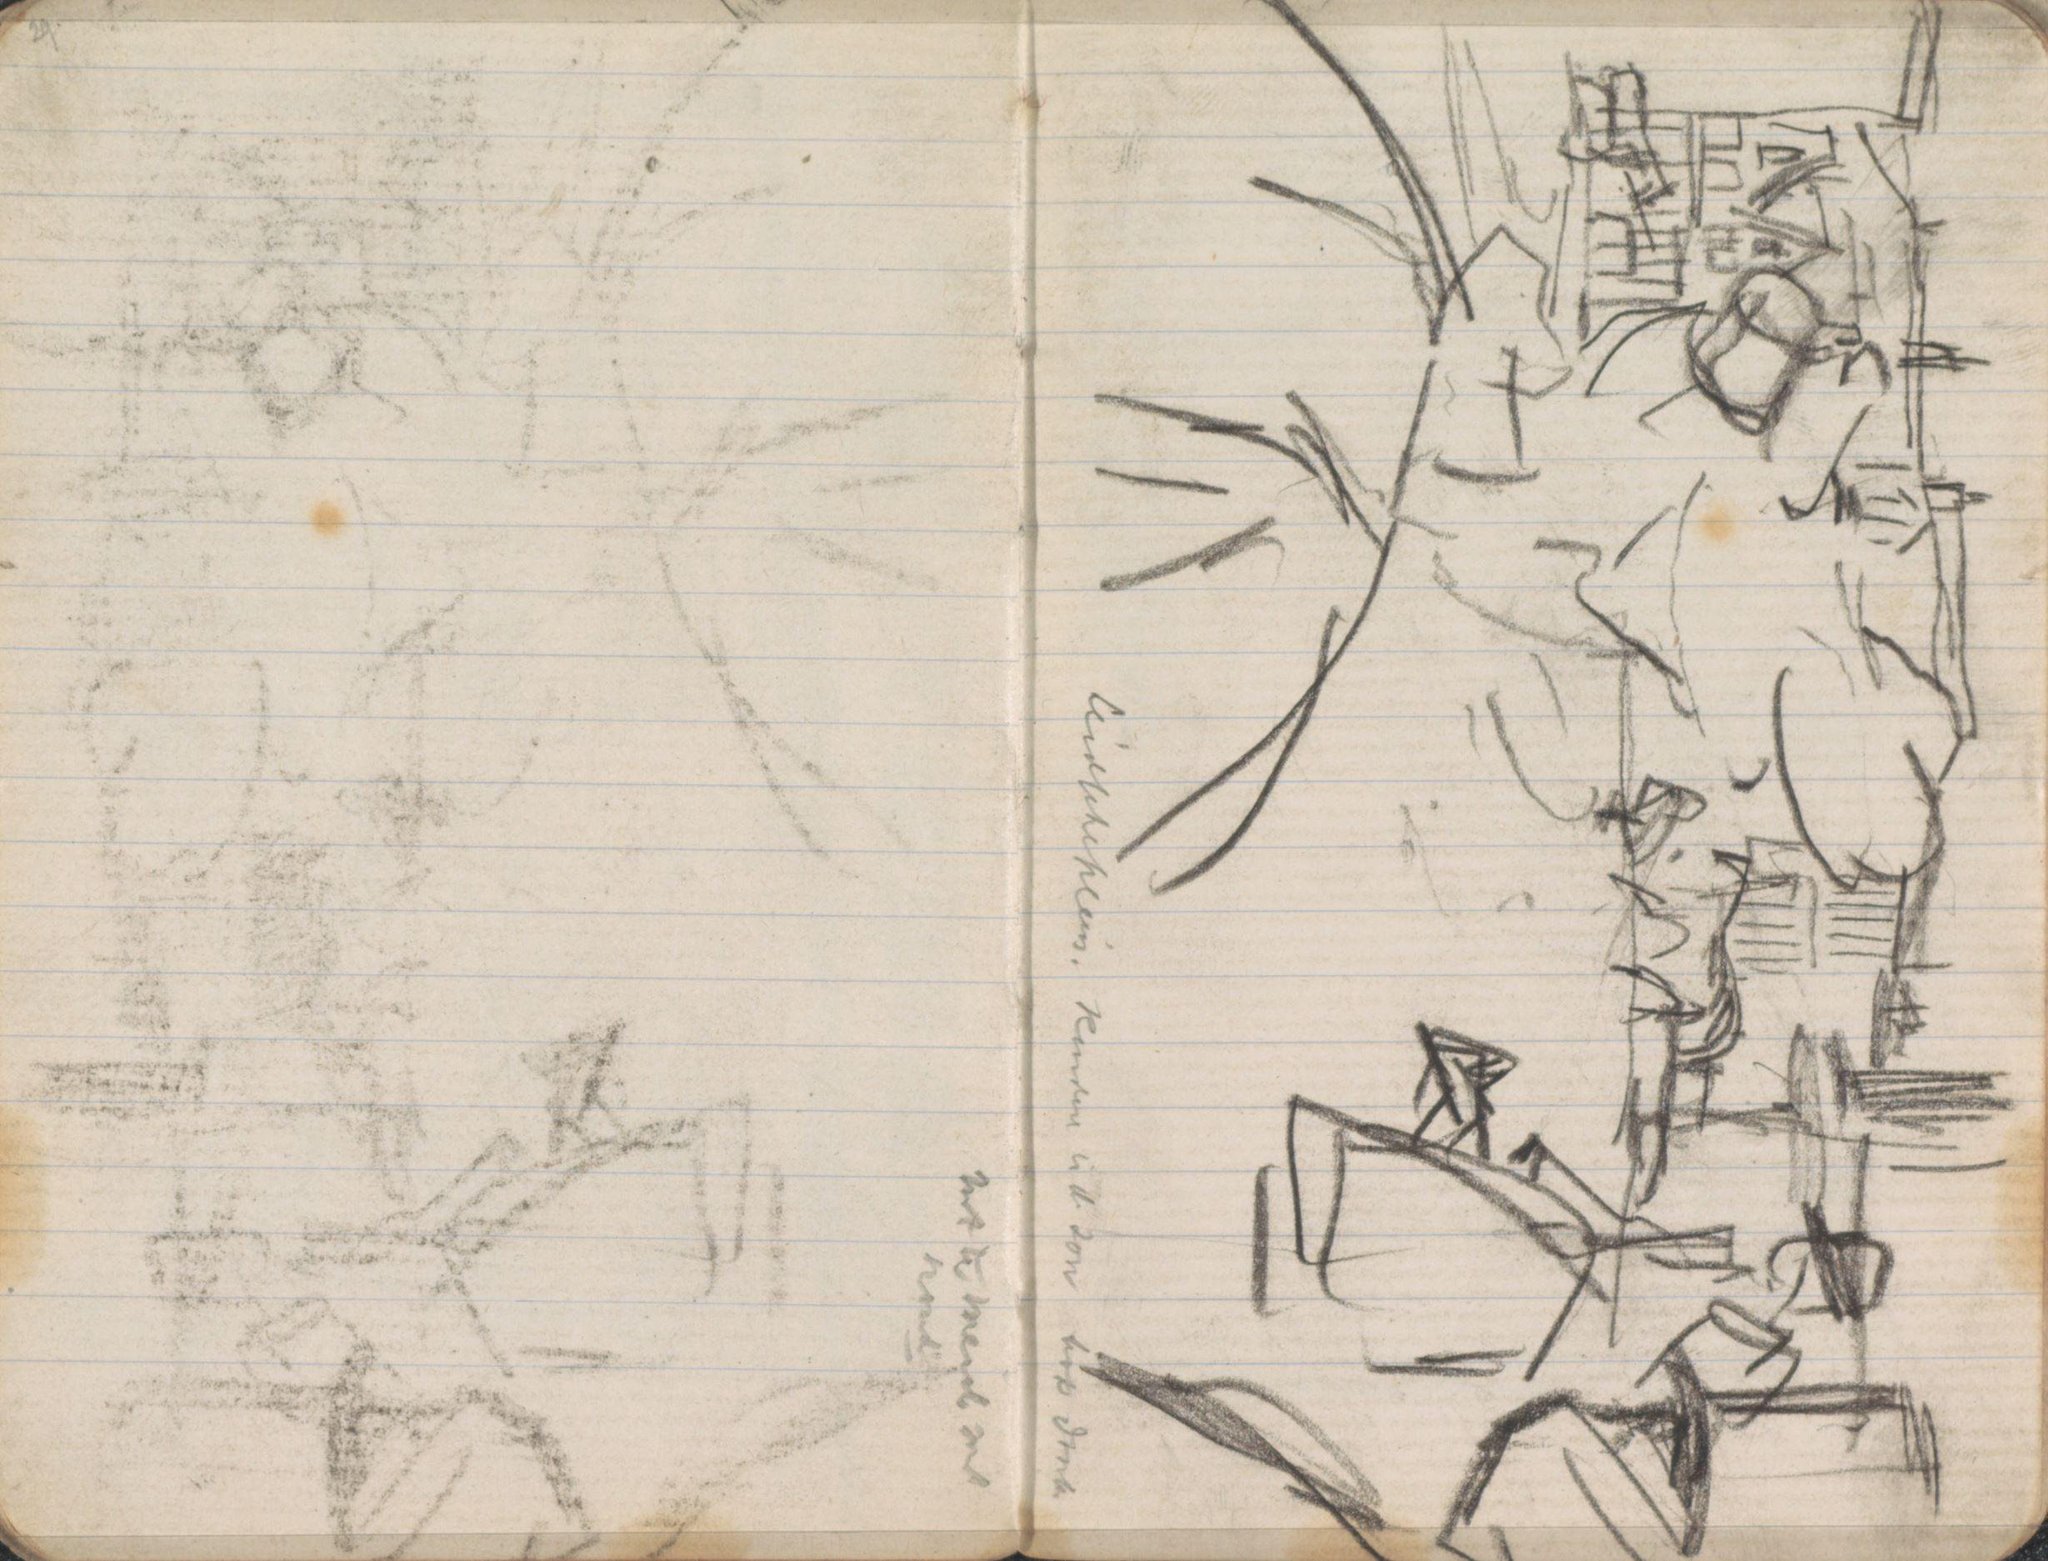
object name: sketchbook leaf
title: Figuren op het Leidseplein in Amsterdam, ter hoogte van het American Hotel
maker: george hendrik breitner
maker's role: draughtsman, painter, print maker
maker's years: 1857-1923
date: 1896-1901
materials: chalk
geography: amsterdam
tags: diligence, omnibus, horse-tram, civic architecture; edifices; dwellings, square, place, circus, etc. (+ city(-scape) with figures, staffage)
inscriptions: annotation: ‘Leidscheplein. [...] in de zon kop donker/ witte meid met/ rood’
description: Op de achtergrond een paardentram. Pagina 29 en pagina 30 uit een schetsboek met 37 bladen.